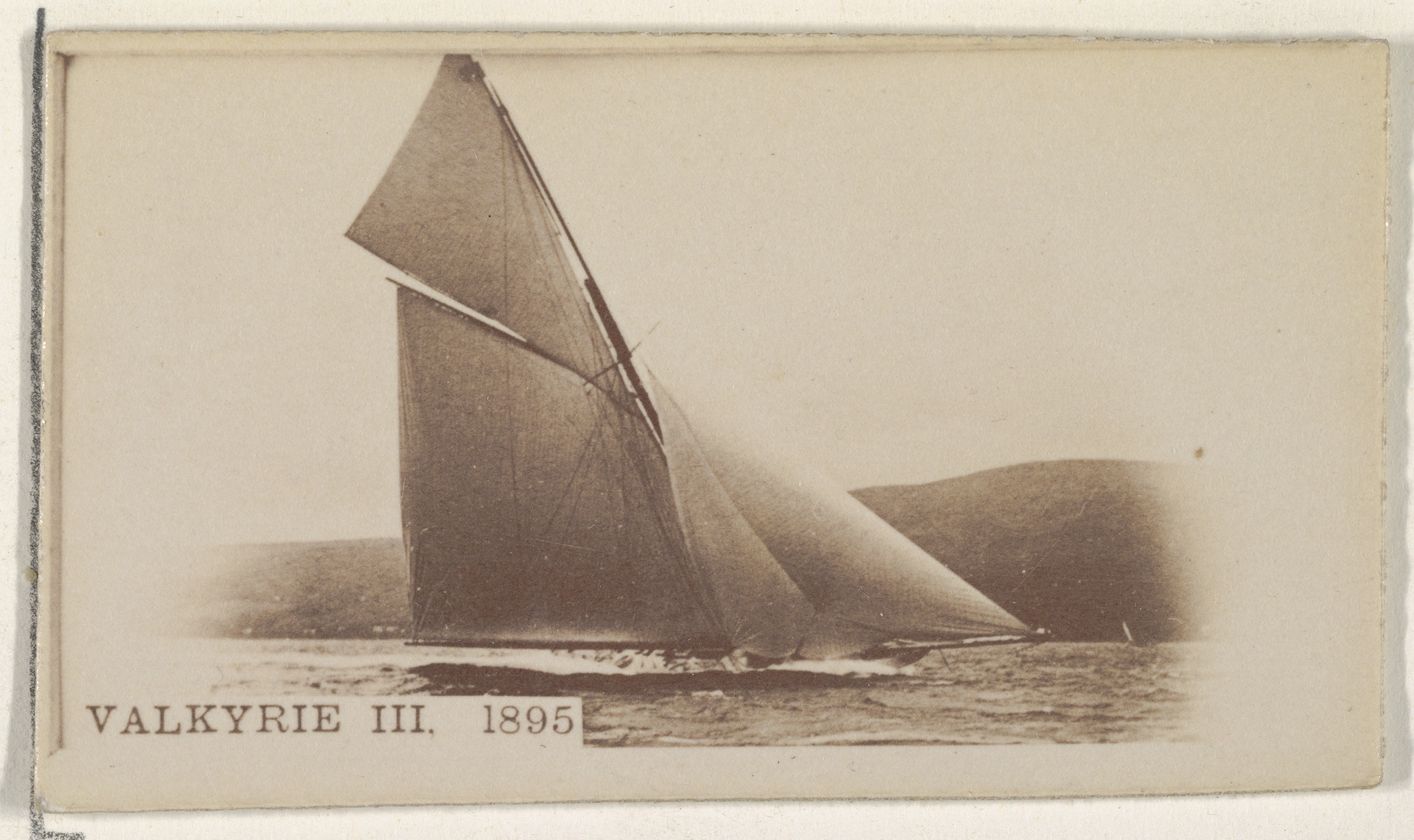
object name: photograph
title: Valkyrie III, 1895, from the Famous Ships series (N50) for Virginia Brights Cigarettes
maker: allen & ginter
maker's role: publisher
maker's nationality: american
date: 1895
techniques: albumen silver print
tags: ships